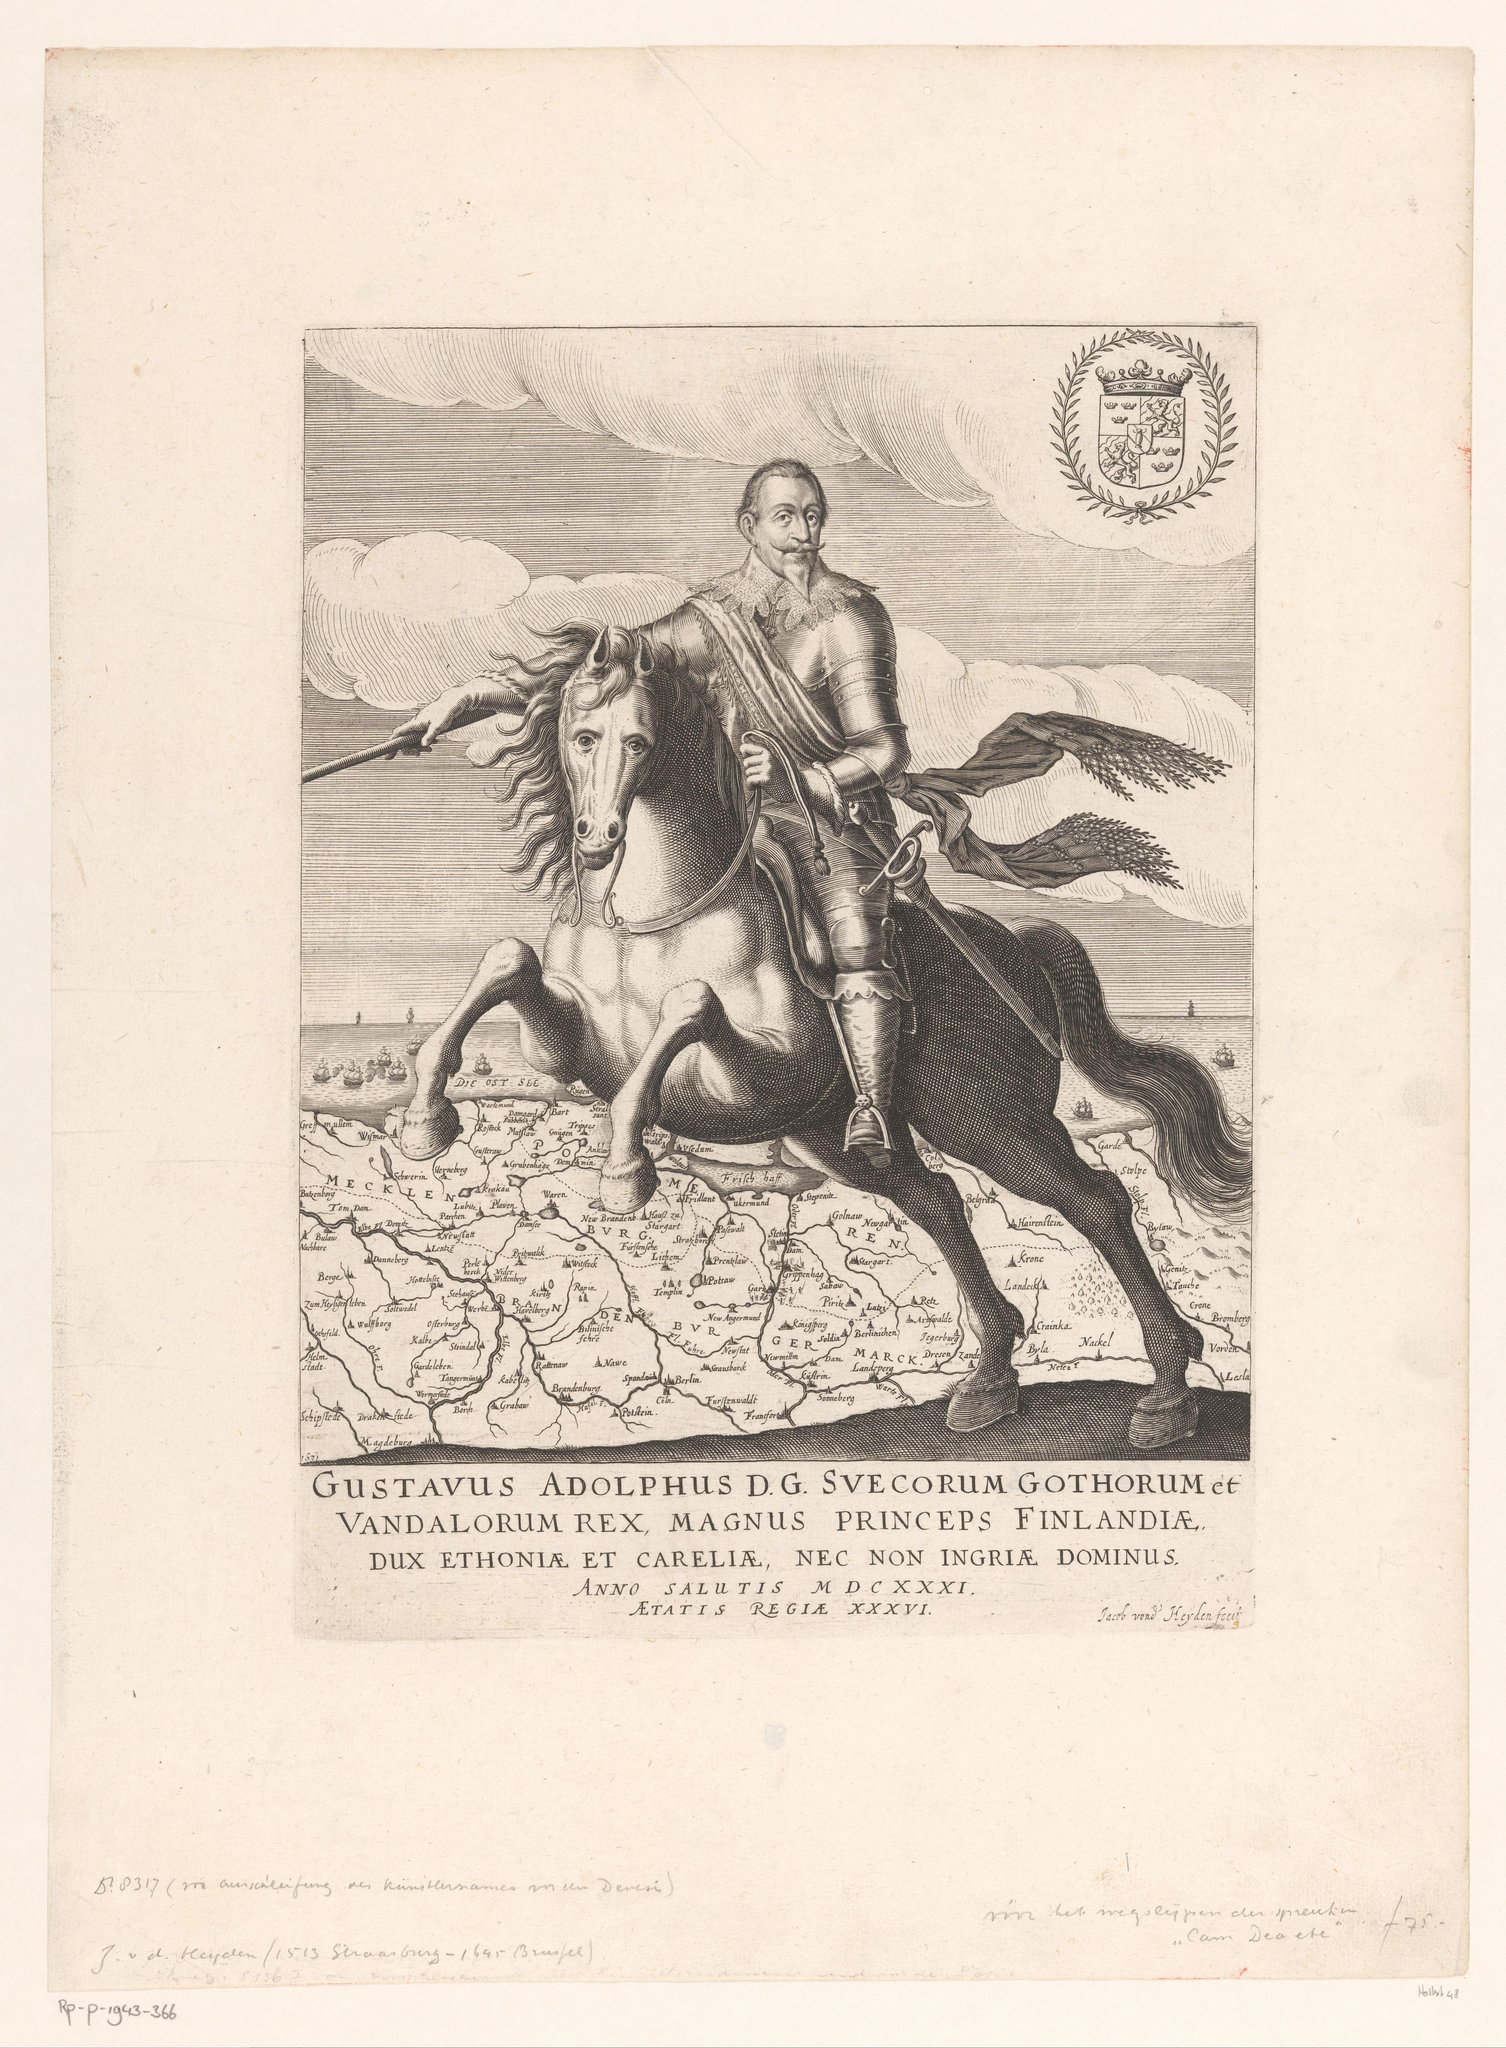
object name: print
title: Ruiterportret van Gustaaf II Adolf, Koning van Zweden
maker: jacob van der heyden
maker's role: draughtsman, print maker, publisher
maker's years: 1573-1645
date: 1631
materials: paper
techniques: engraving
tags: equestrian state-portrait, historical persons, ruler, sovereign, armorial bearing, heraldry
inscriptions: collector's mark: Lugt 2228